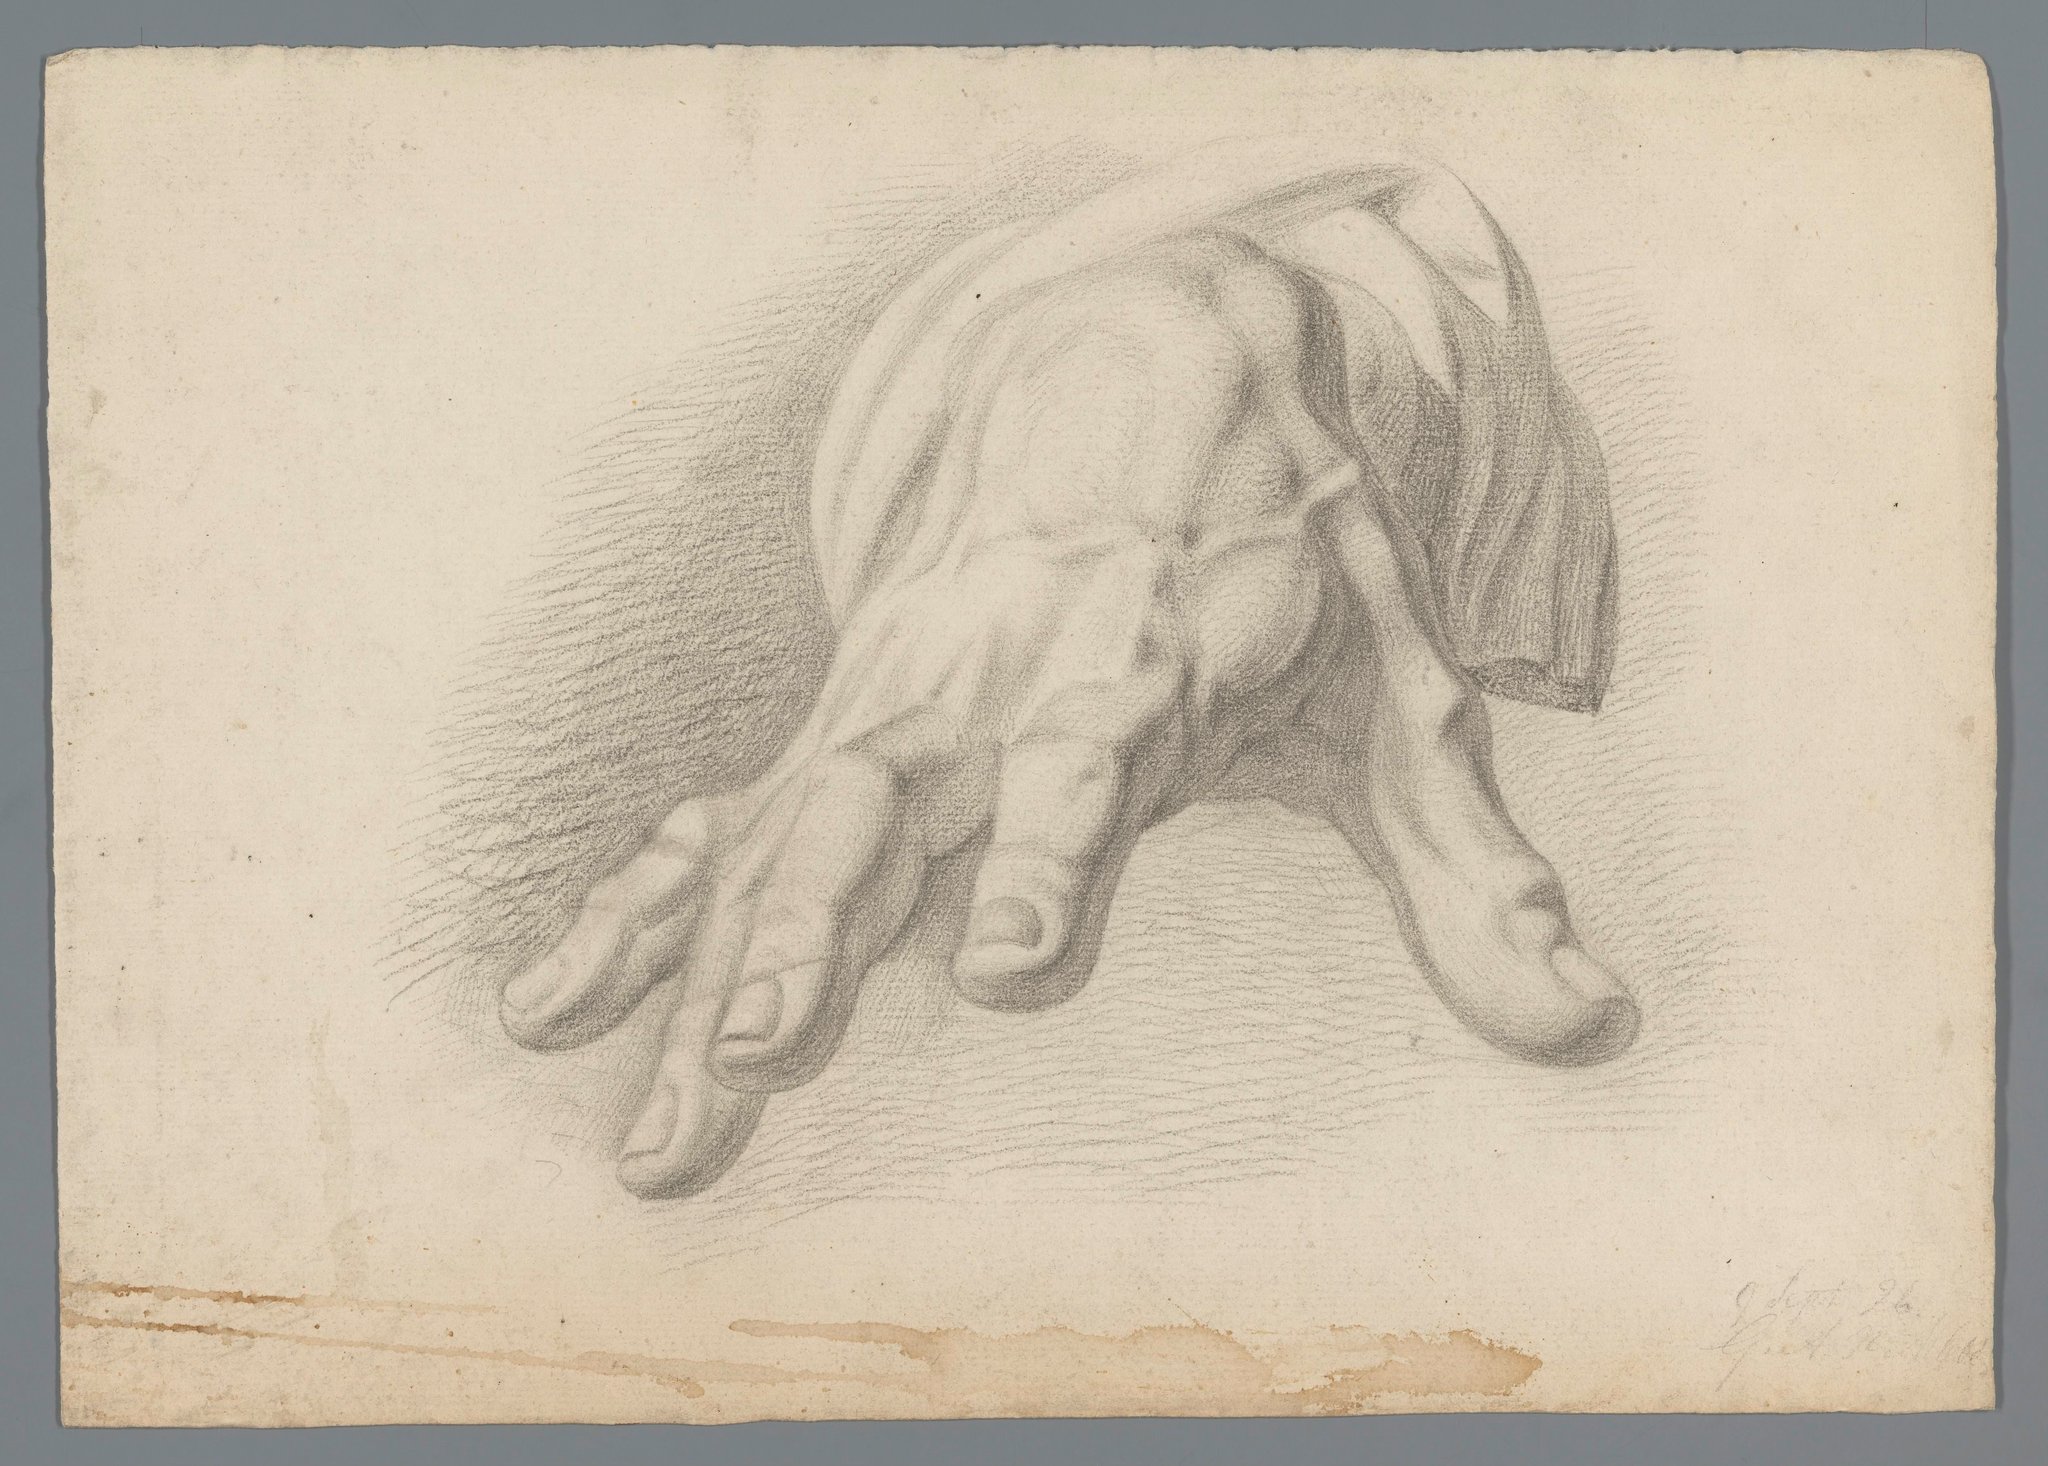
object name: drawing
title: Studie van een hand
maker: gerard allebé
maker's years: 1849-1879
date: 1826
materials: chalk, paper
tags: hand